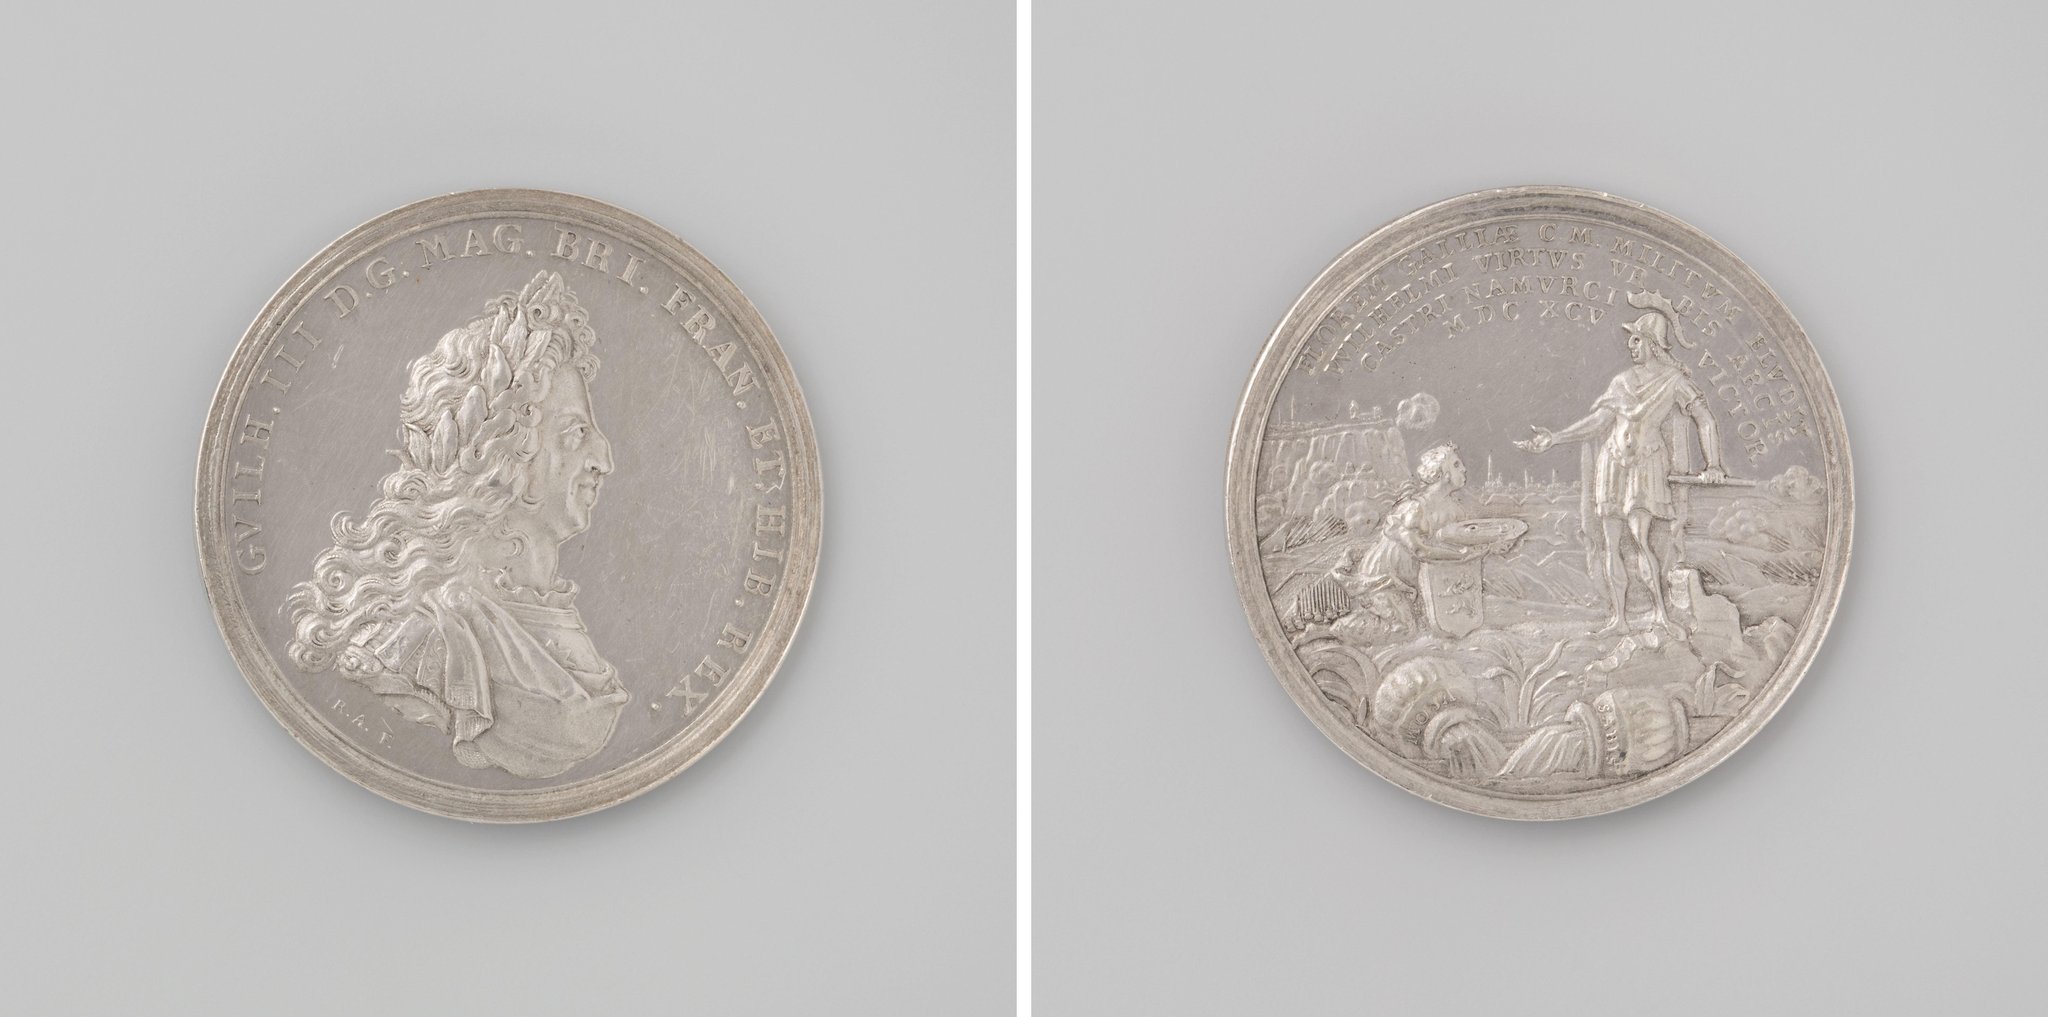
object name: history medal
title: Herovering van Namen door Willem III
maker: reynier arondeaux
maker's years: 1678-1727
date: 1695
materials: silver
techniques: striking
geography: amsterdam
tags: the hague, william iii (prince of orange and king of england, scotland, and ireland)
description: Zilveren penning. Voorzijde: borststuk man met lauwerkrans binnen omschrift. Keerzijde: stad Namen in gedaante van knielende vrouw biedt Willem III in Romeinse kledij sleutels aan binnen driedubbel omschrift.